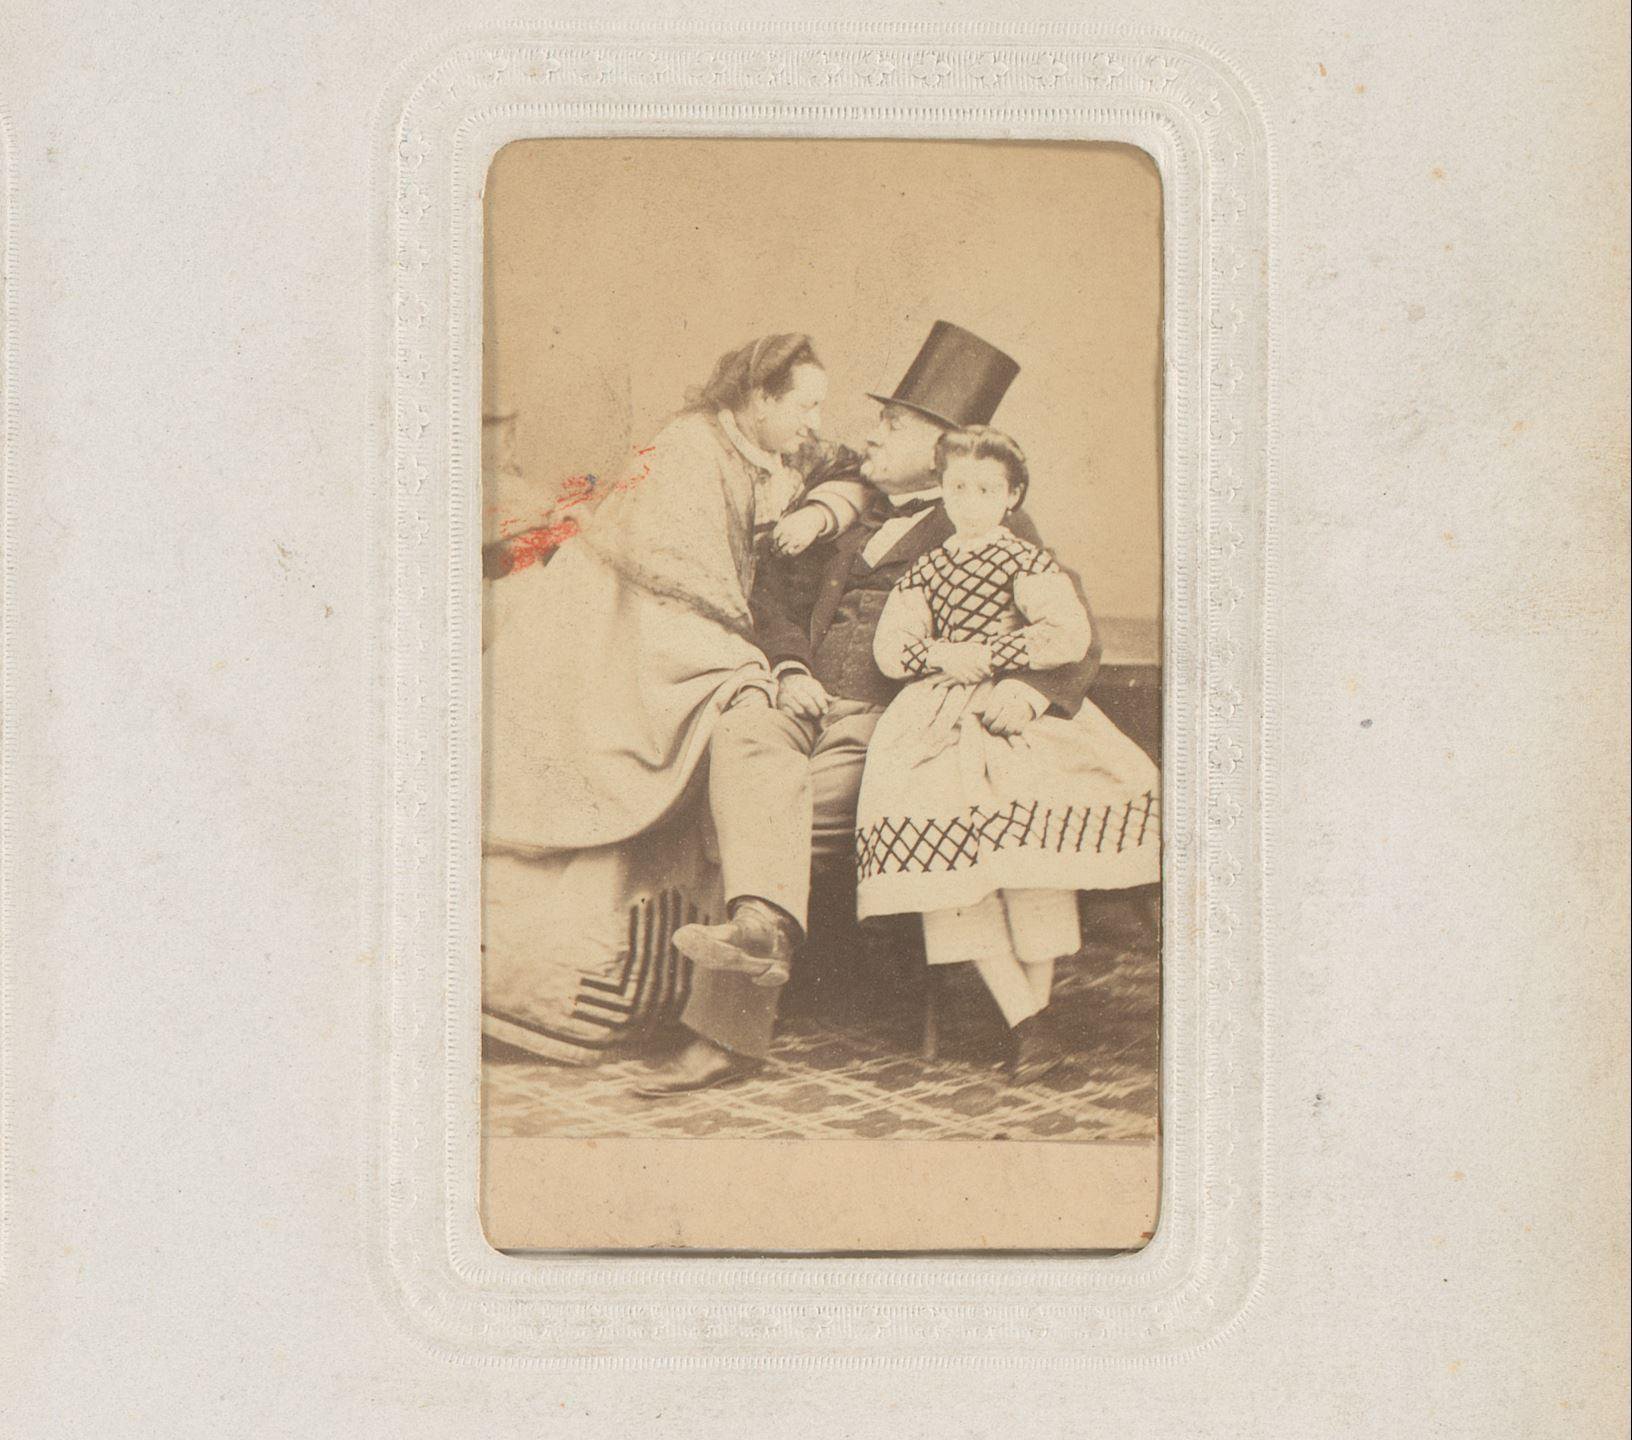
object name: album leaf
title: Groepsportret met vader, moeder en dochter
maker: rovira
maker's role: fotograaf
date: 1860-1890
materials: cardboard, photographic support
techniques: albumen print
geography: spain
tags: family group, especially parents with their child(ren), head-gear: top hat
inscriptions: inscription: ‘Rovira/ Fotógrafo/ Lorca’